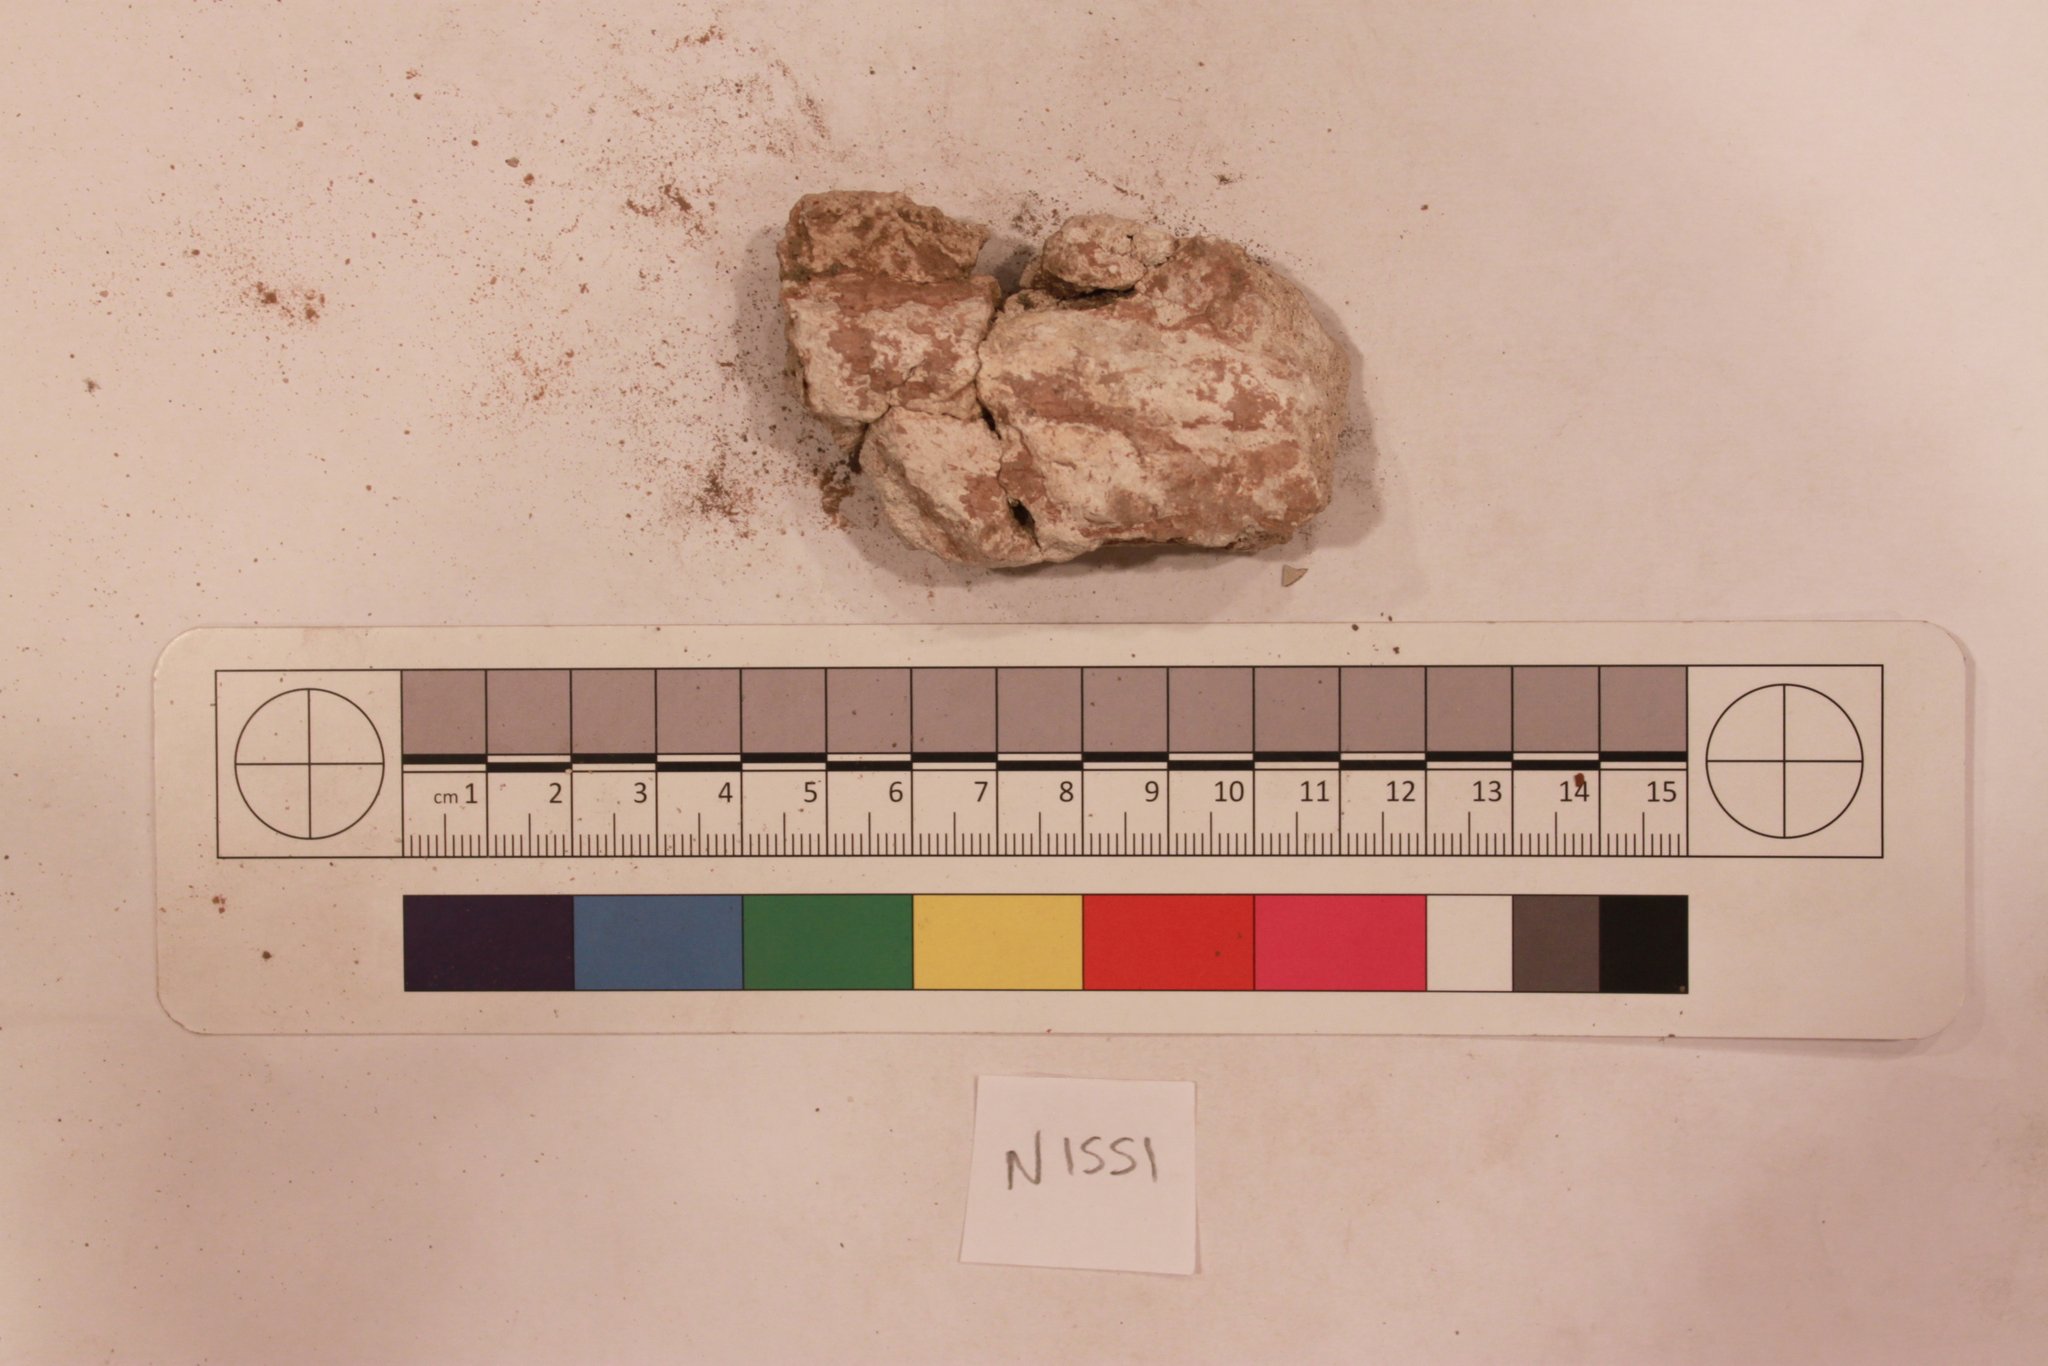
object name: fragment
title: Stucco Fragment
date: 701-1200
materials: plaster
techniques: carving, painting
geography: iran